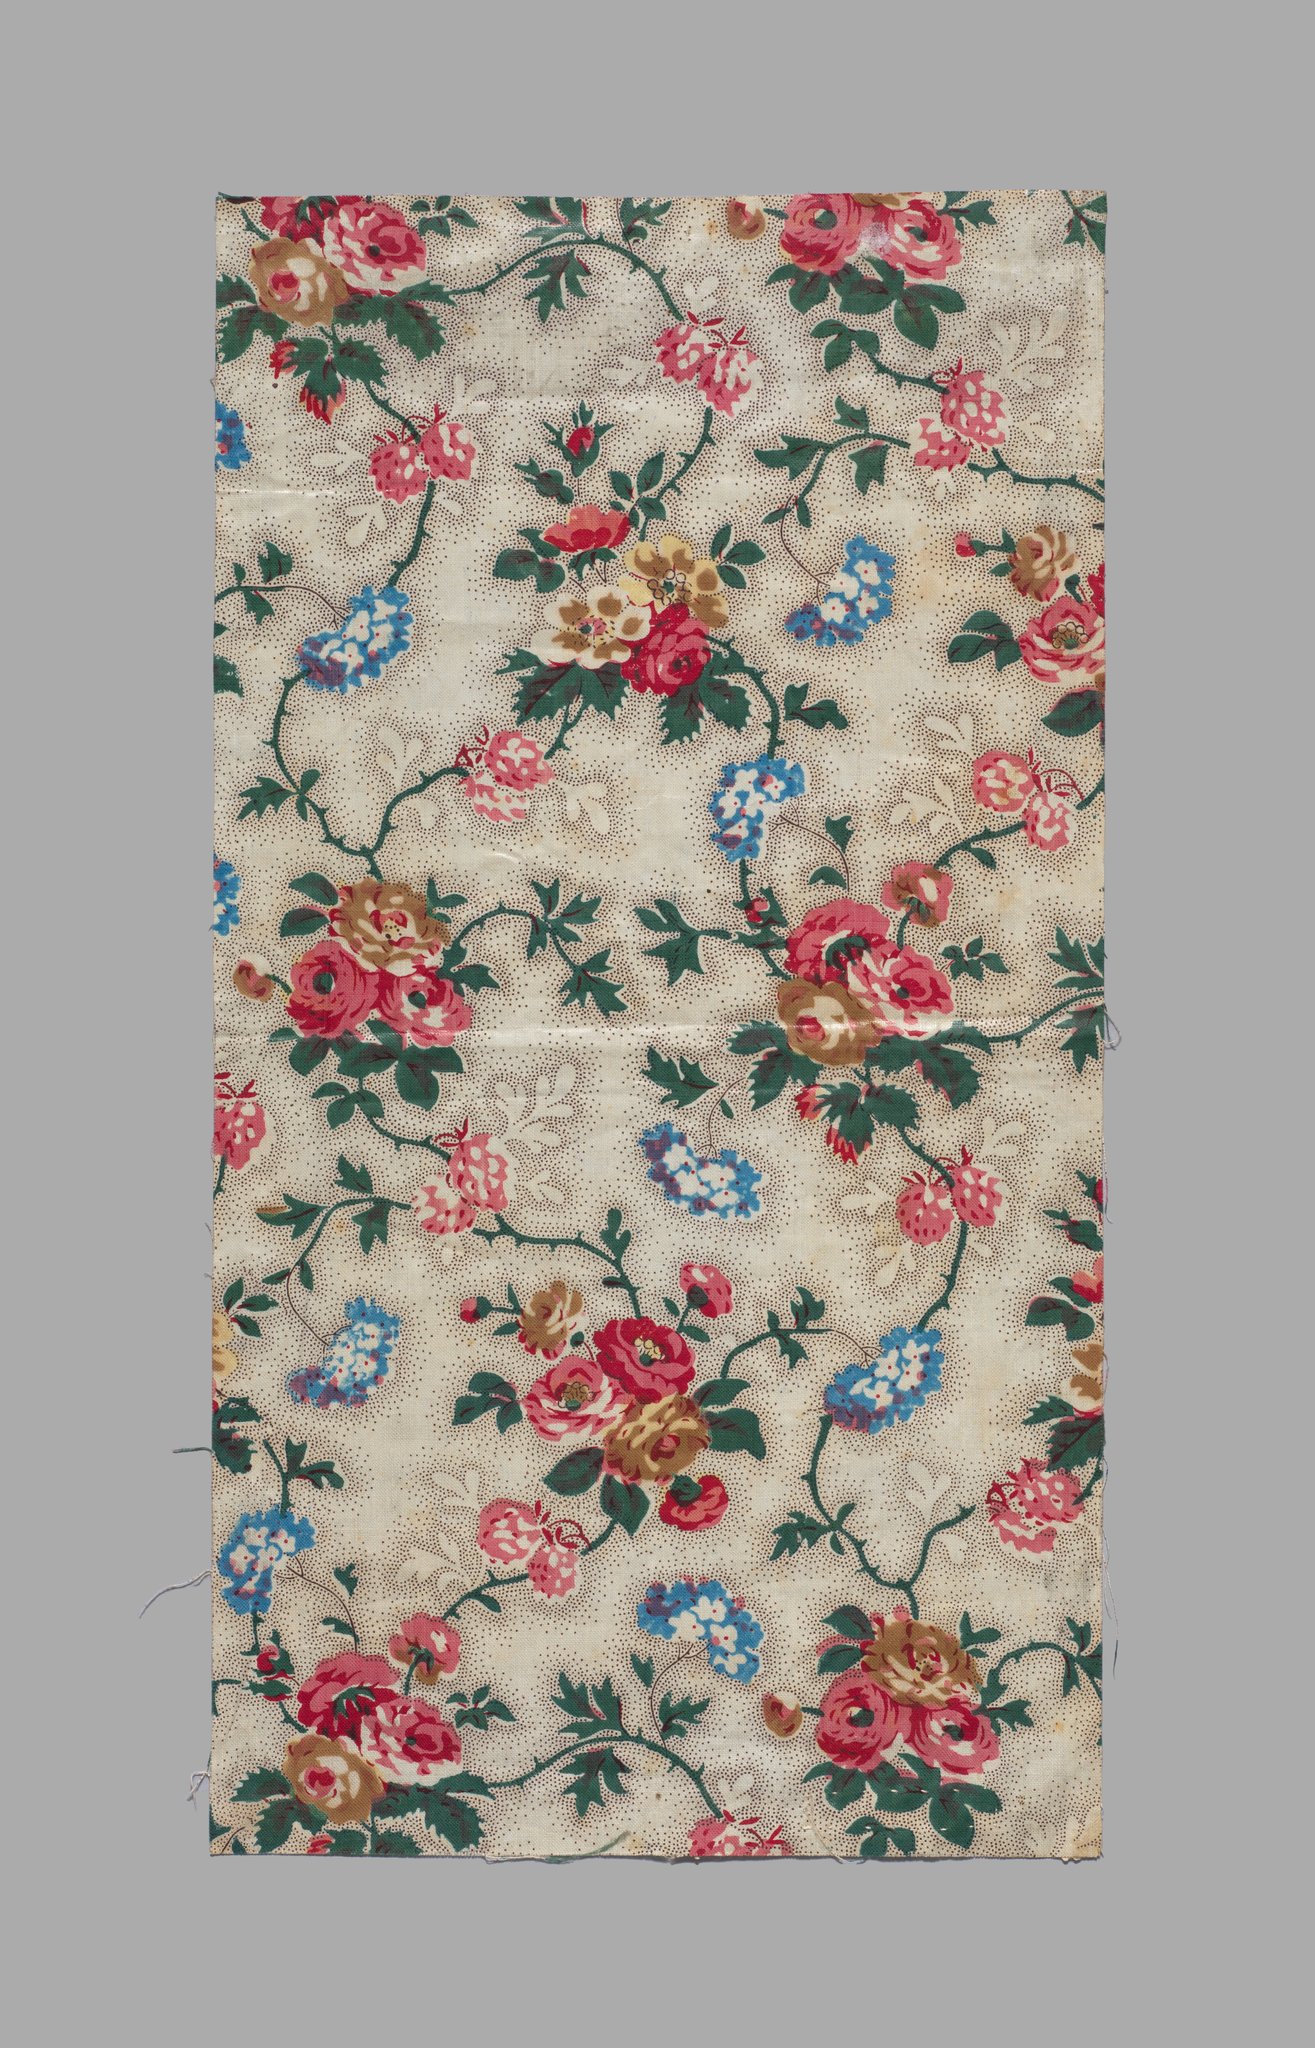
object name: piece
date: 1801-1900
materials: cotton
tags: flowers